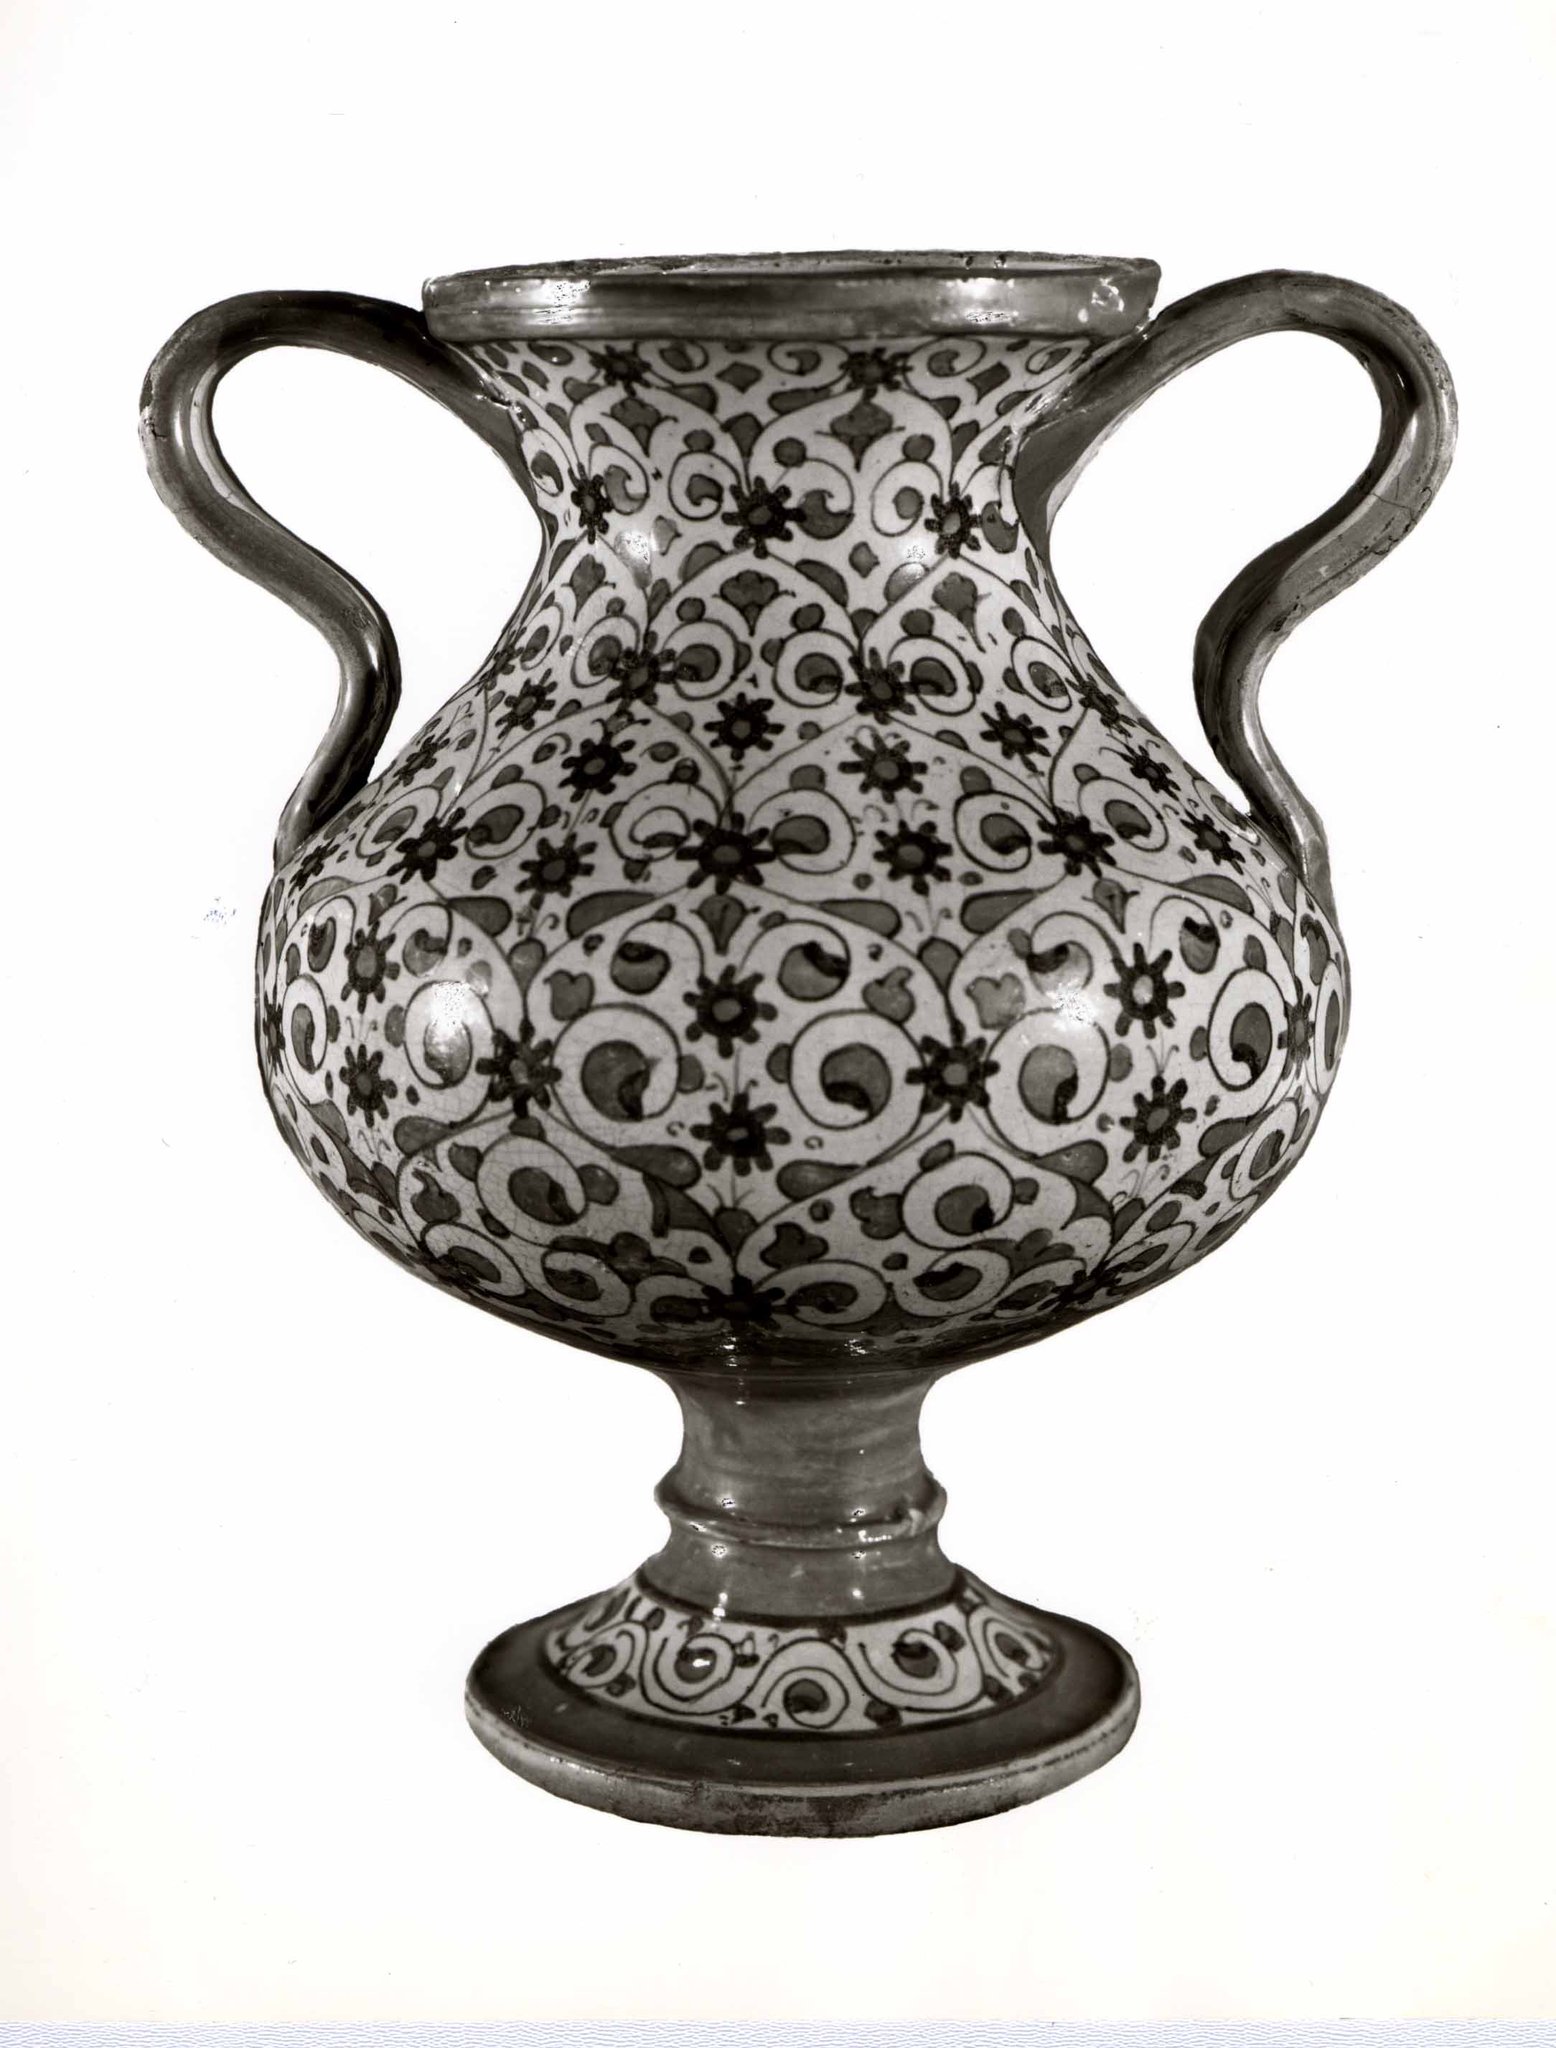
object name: vase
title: Vase (vaso)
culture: italian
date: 1530-1540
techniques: maiolica, glazing